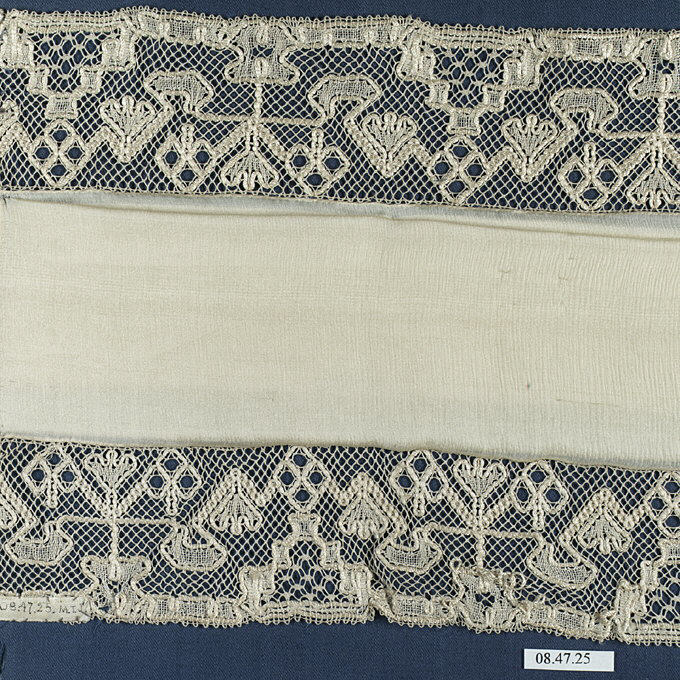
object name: rabat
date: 1801-1900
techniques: lace